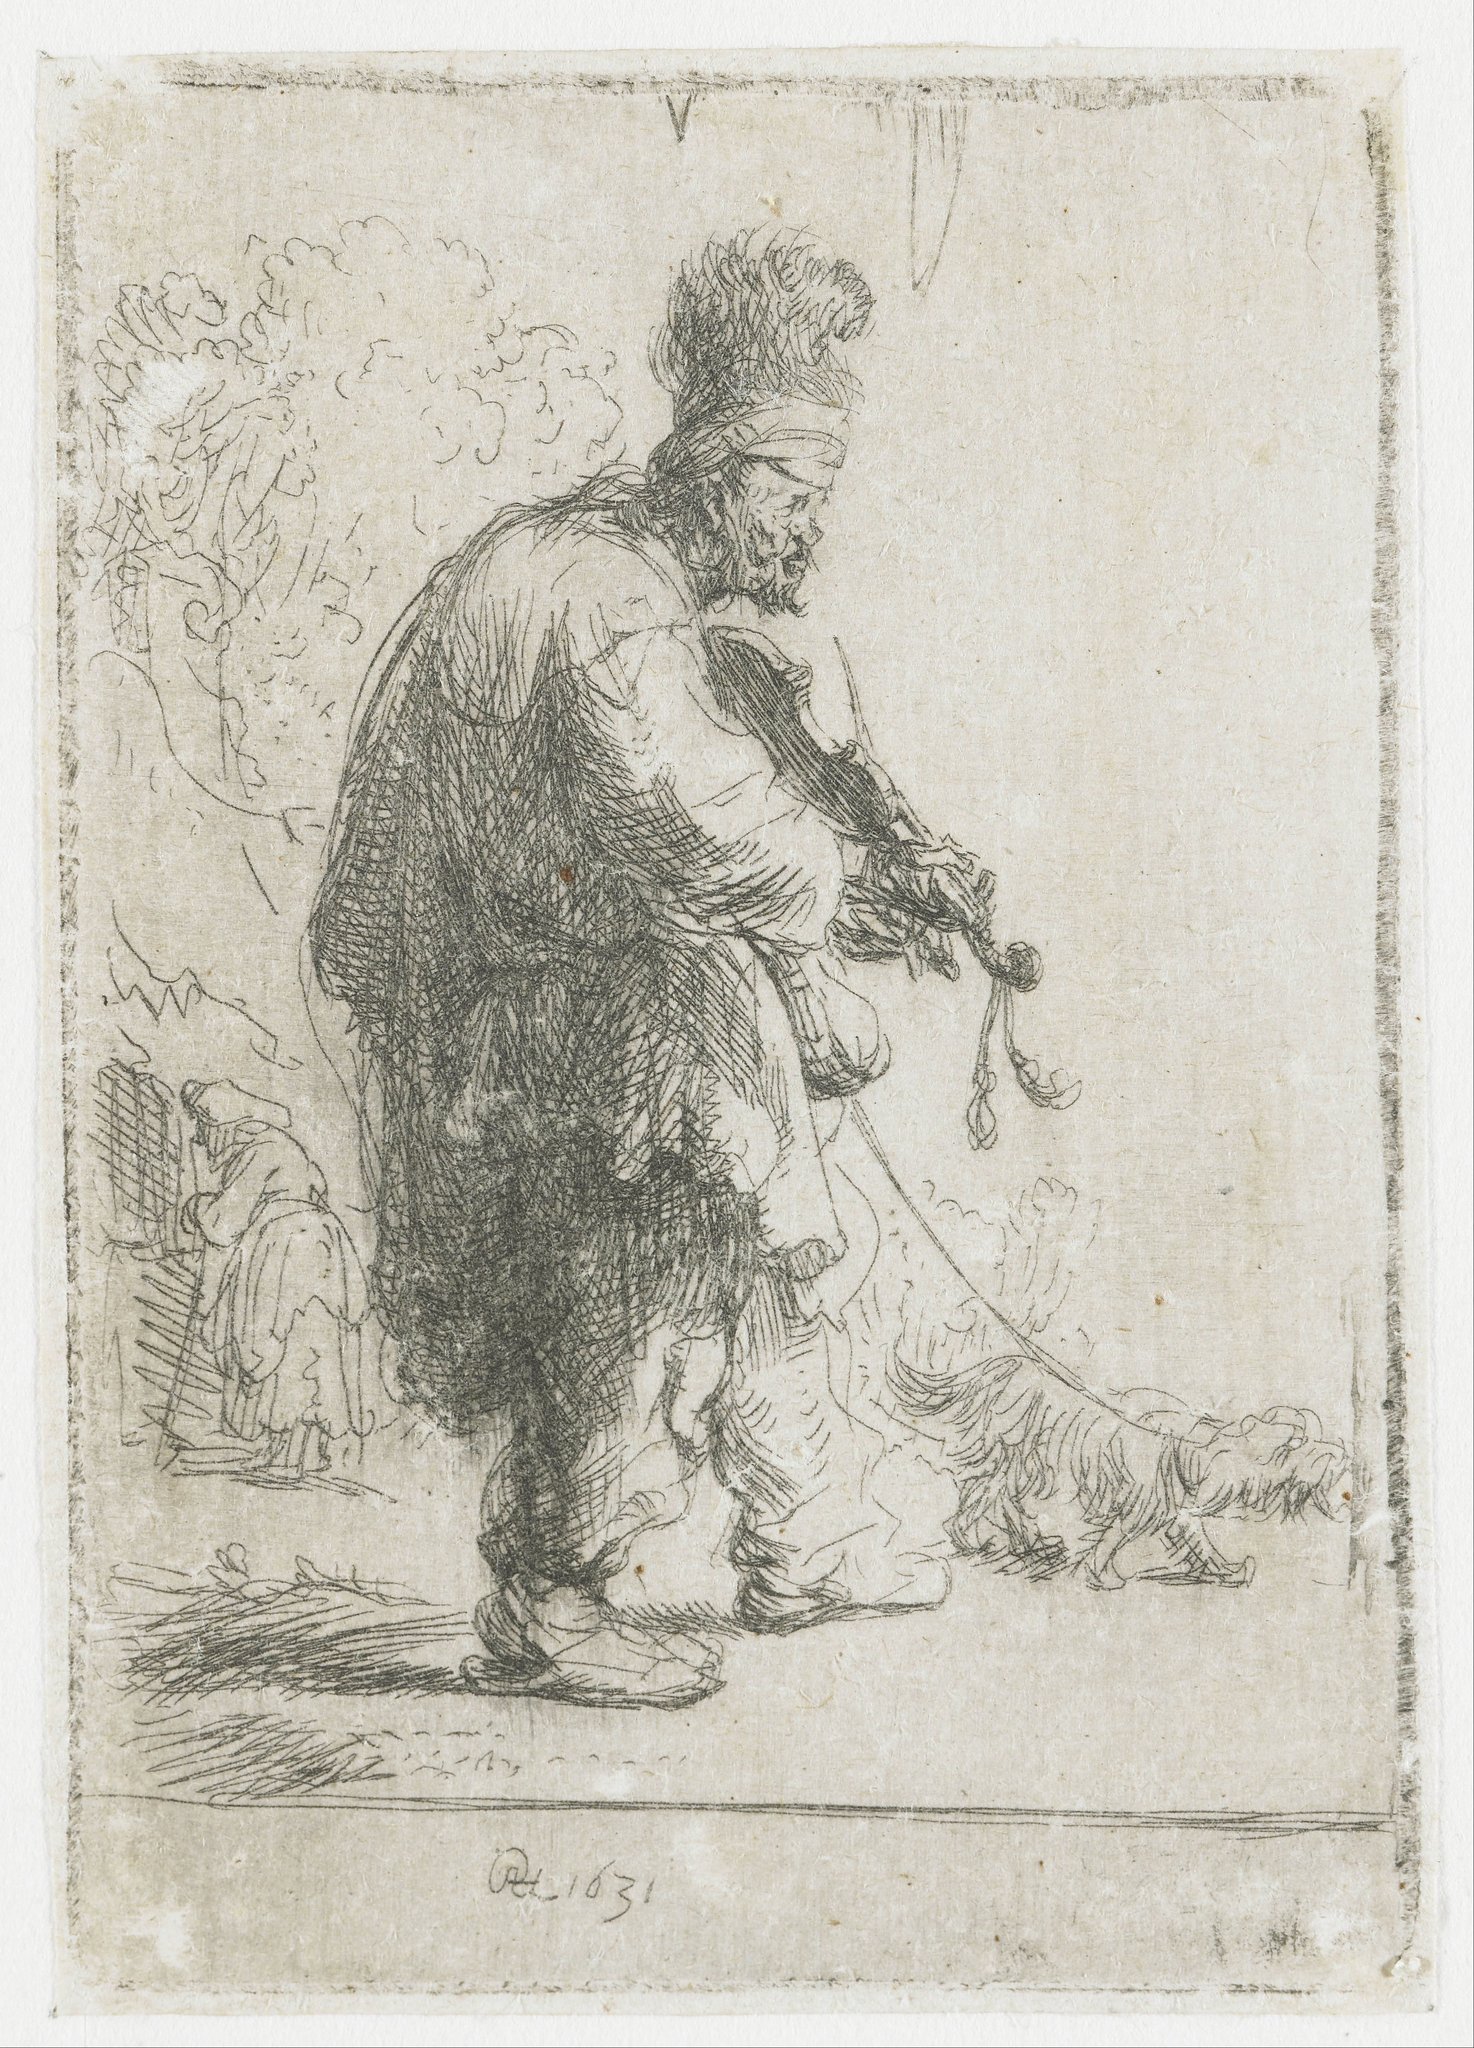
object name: print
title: The blind fiddler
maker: rembrandt van rijn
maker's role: draughtsman, painter, print maker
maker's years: 1606-1669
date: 1631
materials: paper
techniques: etching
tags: violin, fiddle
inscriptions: monogram and date: ‘RHL 1631’, mark: Lugt 240